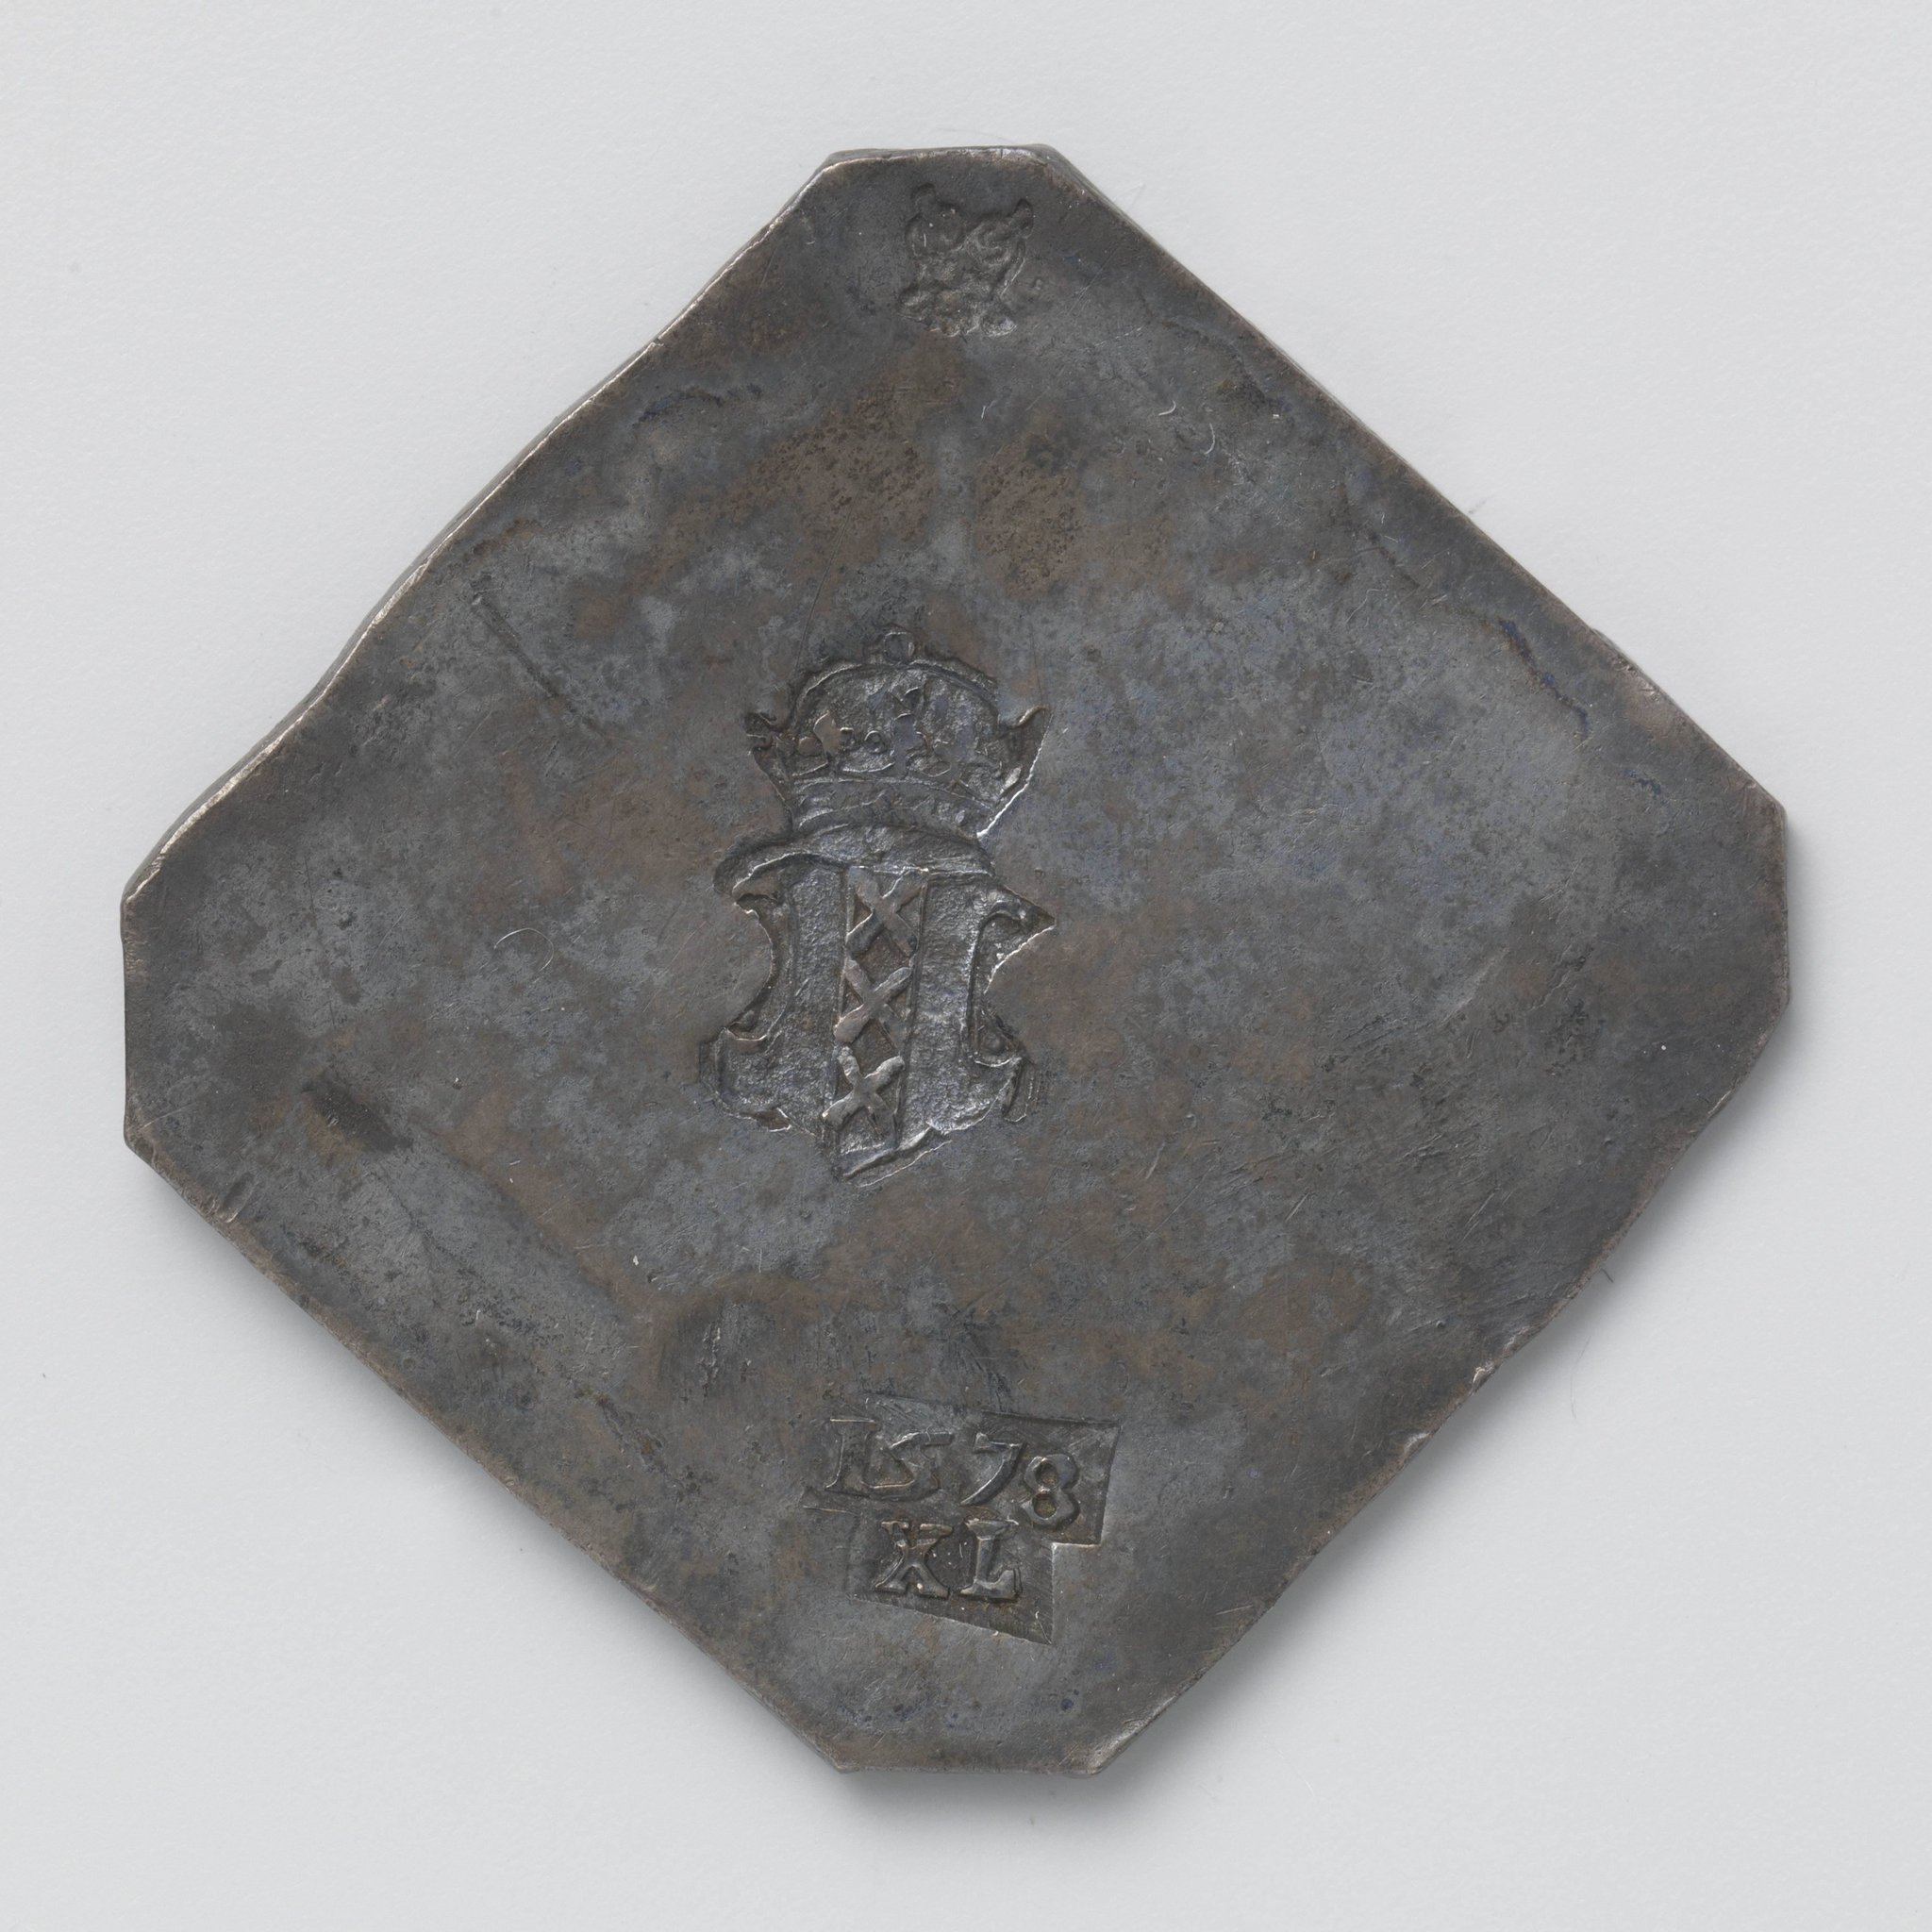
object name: coin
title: Veertig stuiver, noodmunt uit Amsterdam, geslagen na het beleg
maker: Anonymous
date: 1578-1631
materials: silver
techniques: striking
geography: amsterdam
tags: amsterdam